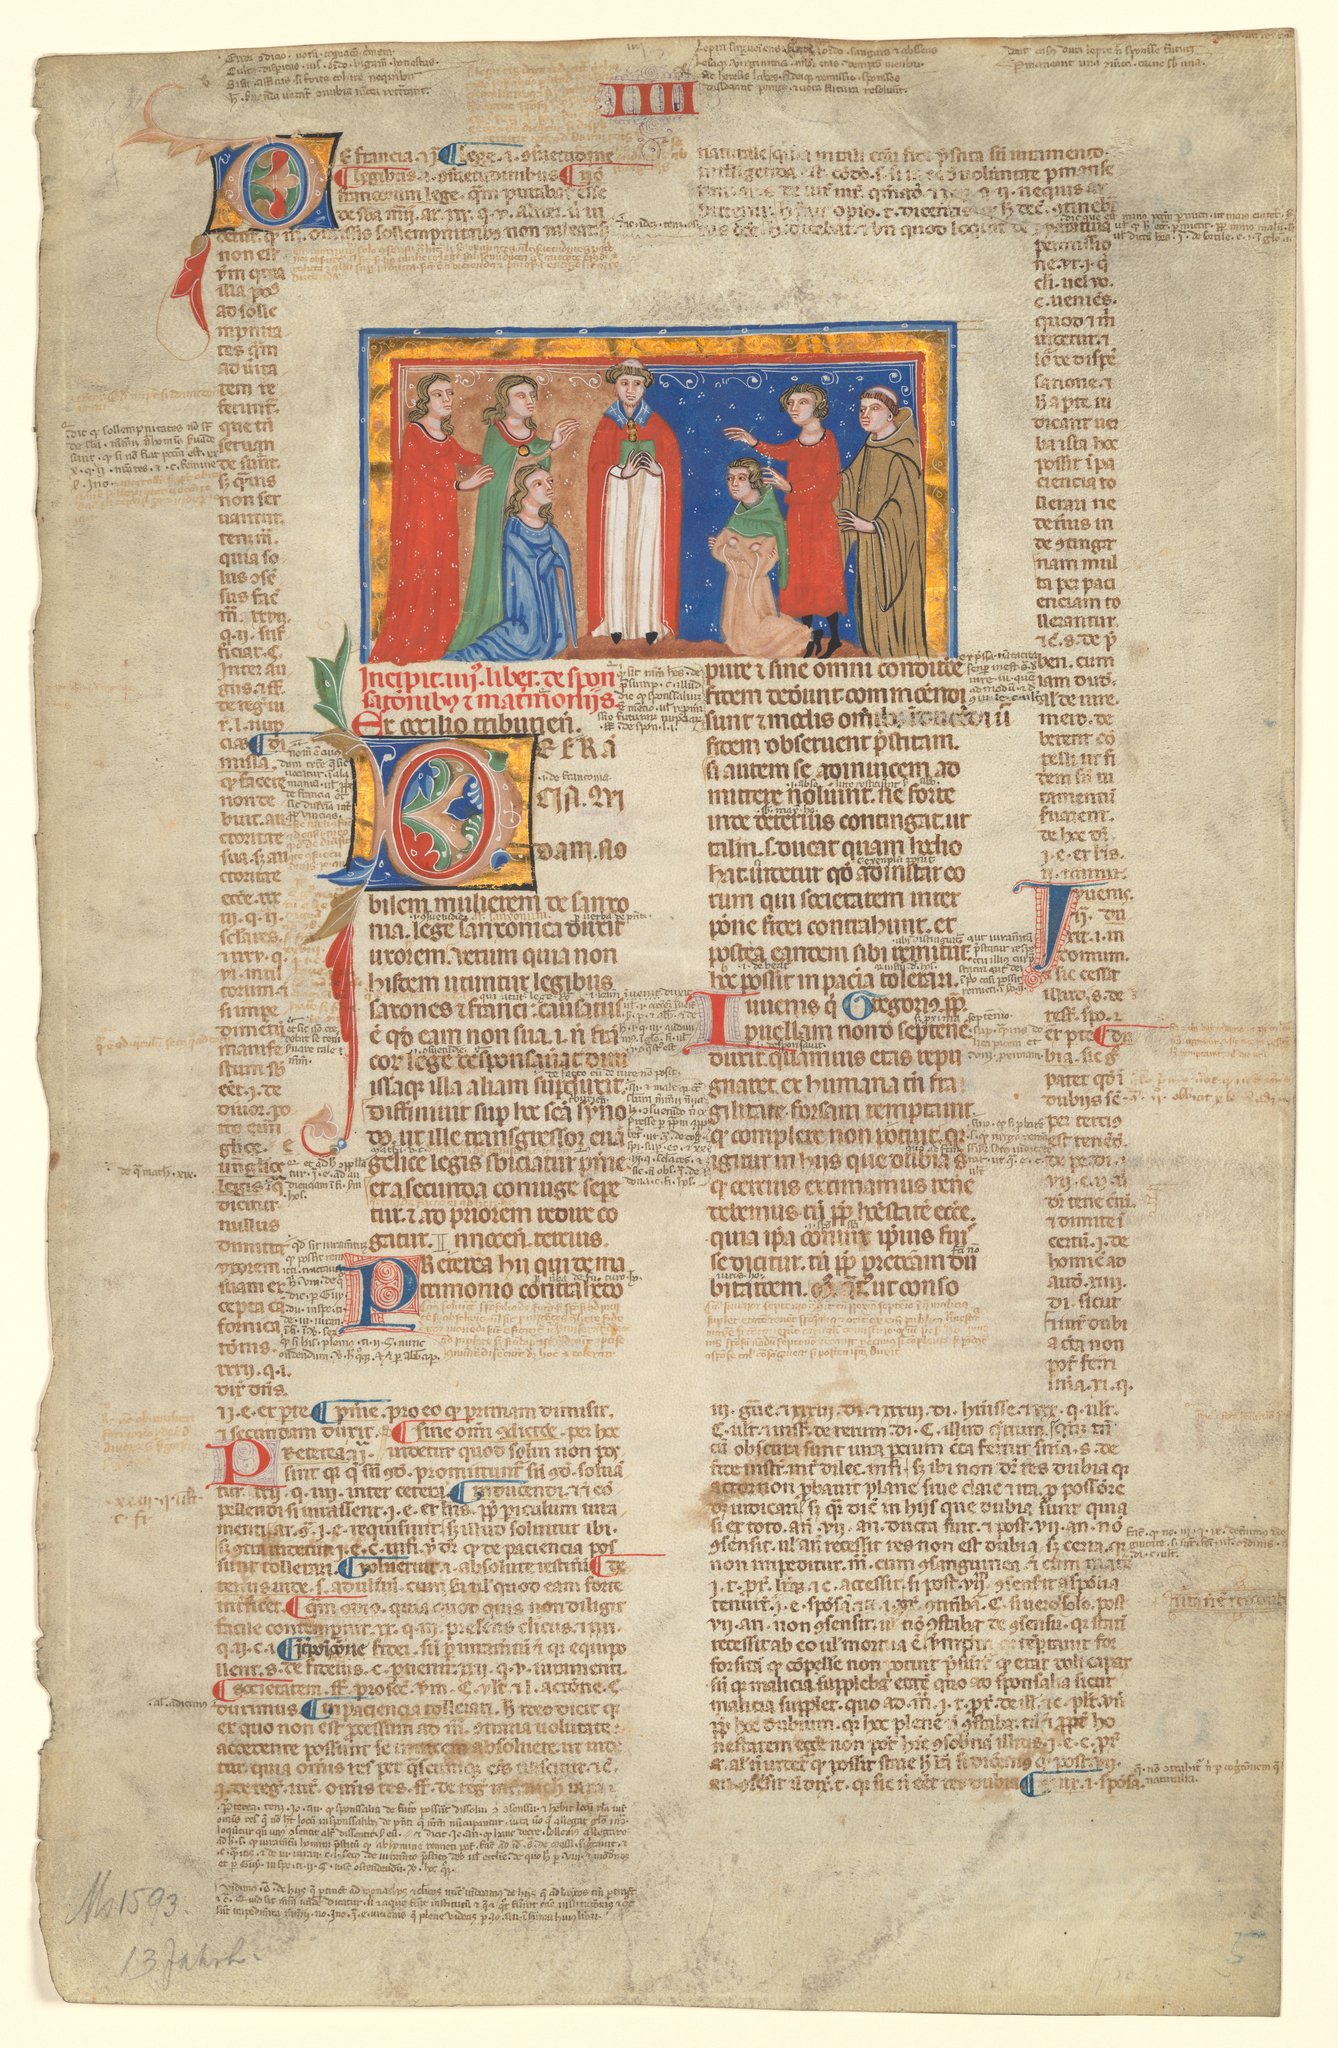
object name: manuscript leaf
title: Manuscript Leaf with Marriage Scene, from Decretals of Gregory IX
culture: italian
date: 1300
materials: gold, ink, parchment, paint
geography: italy